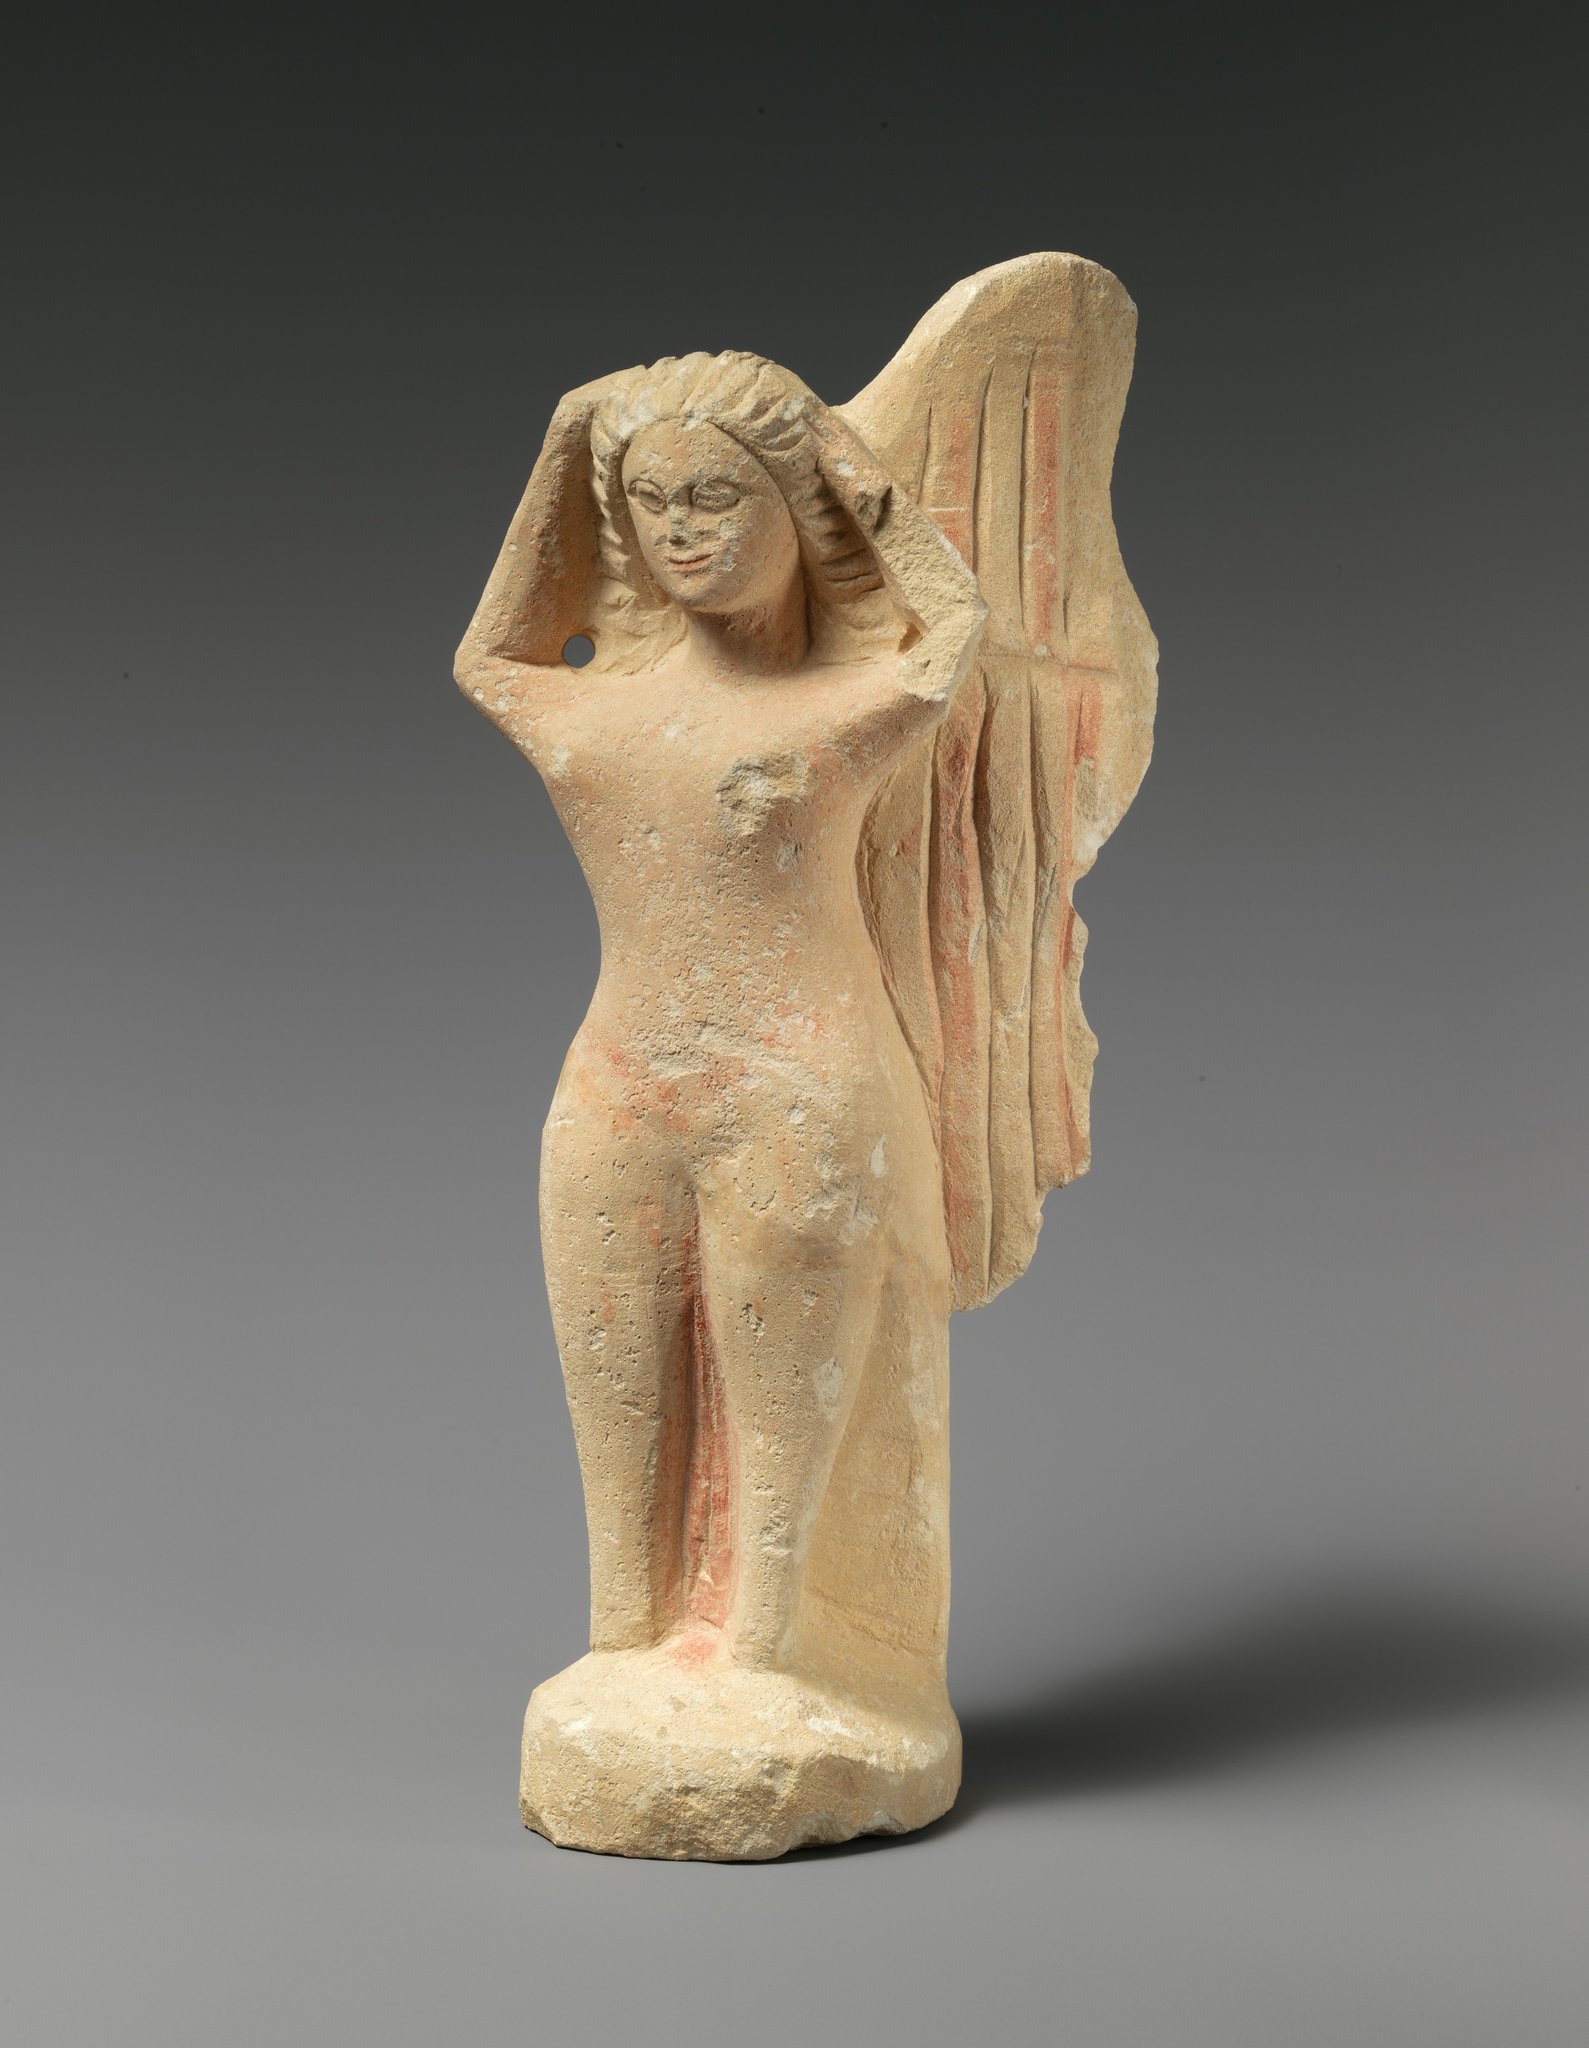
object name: statue of a harpy or siren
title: Limestone statuette of a mourning siren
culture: cypriot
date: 300-201 BCE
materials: limestone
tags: human figures